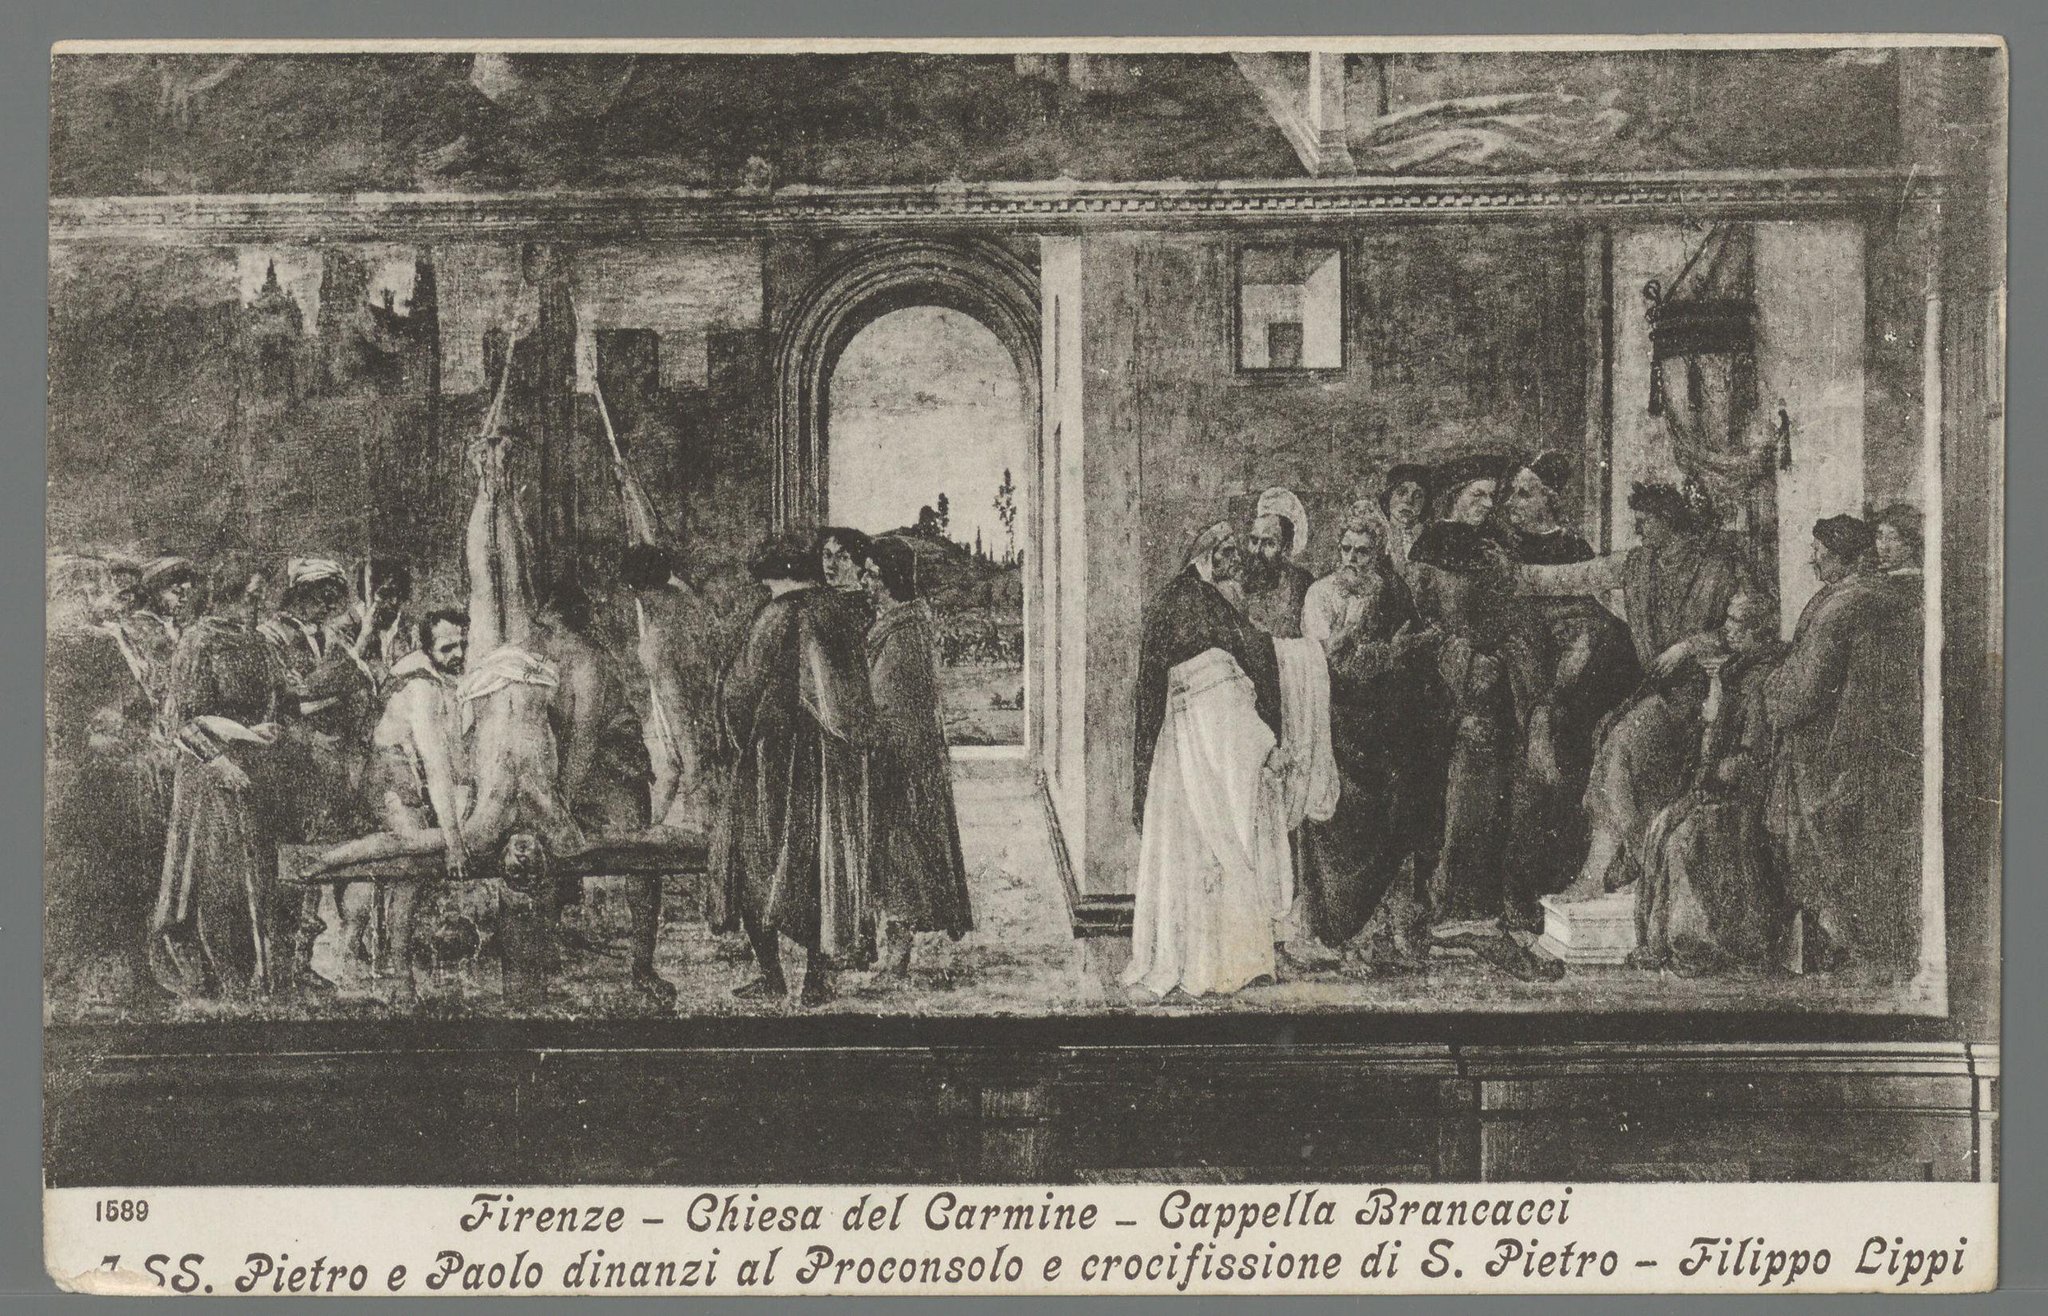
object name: ansichtkaart, prentbriefkaart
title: Firenze. Chiesa del Carmine. Cappella Brancacci. I SS. Pietro e Paolo dinanzi al Proconsolo e crocifissione di S. Pietro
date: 1906-1930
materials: cardboard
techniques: photograph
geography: florence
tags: interior of church, picture, painting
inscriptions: collector's mark: ‘AFE v S’